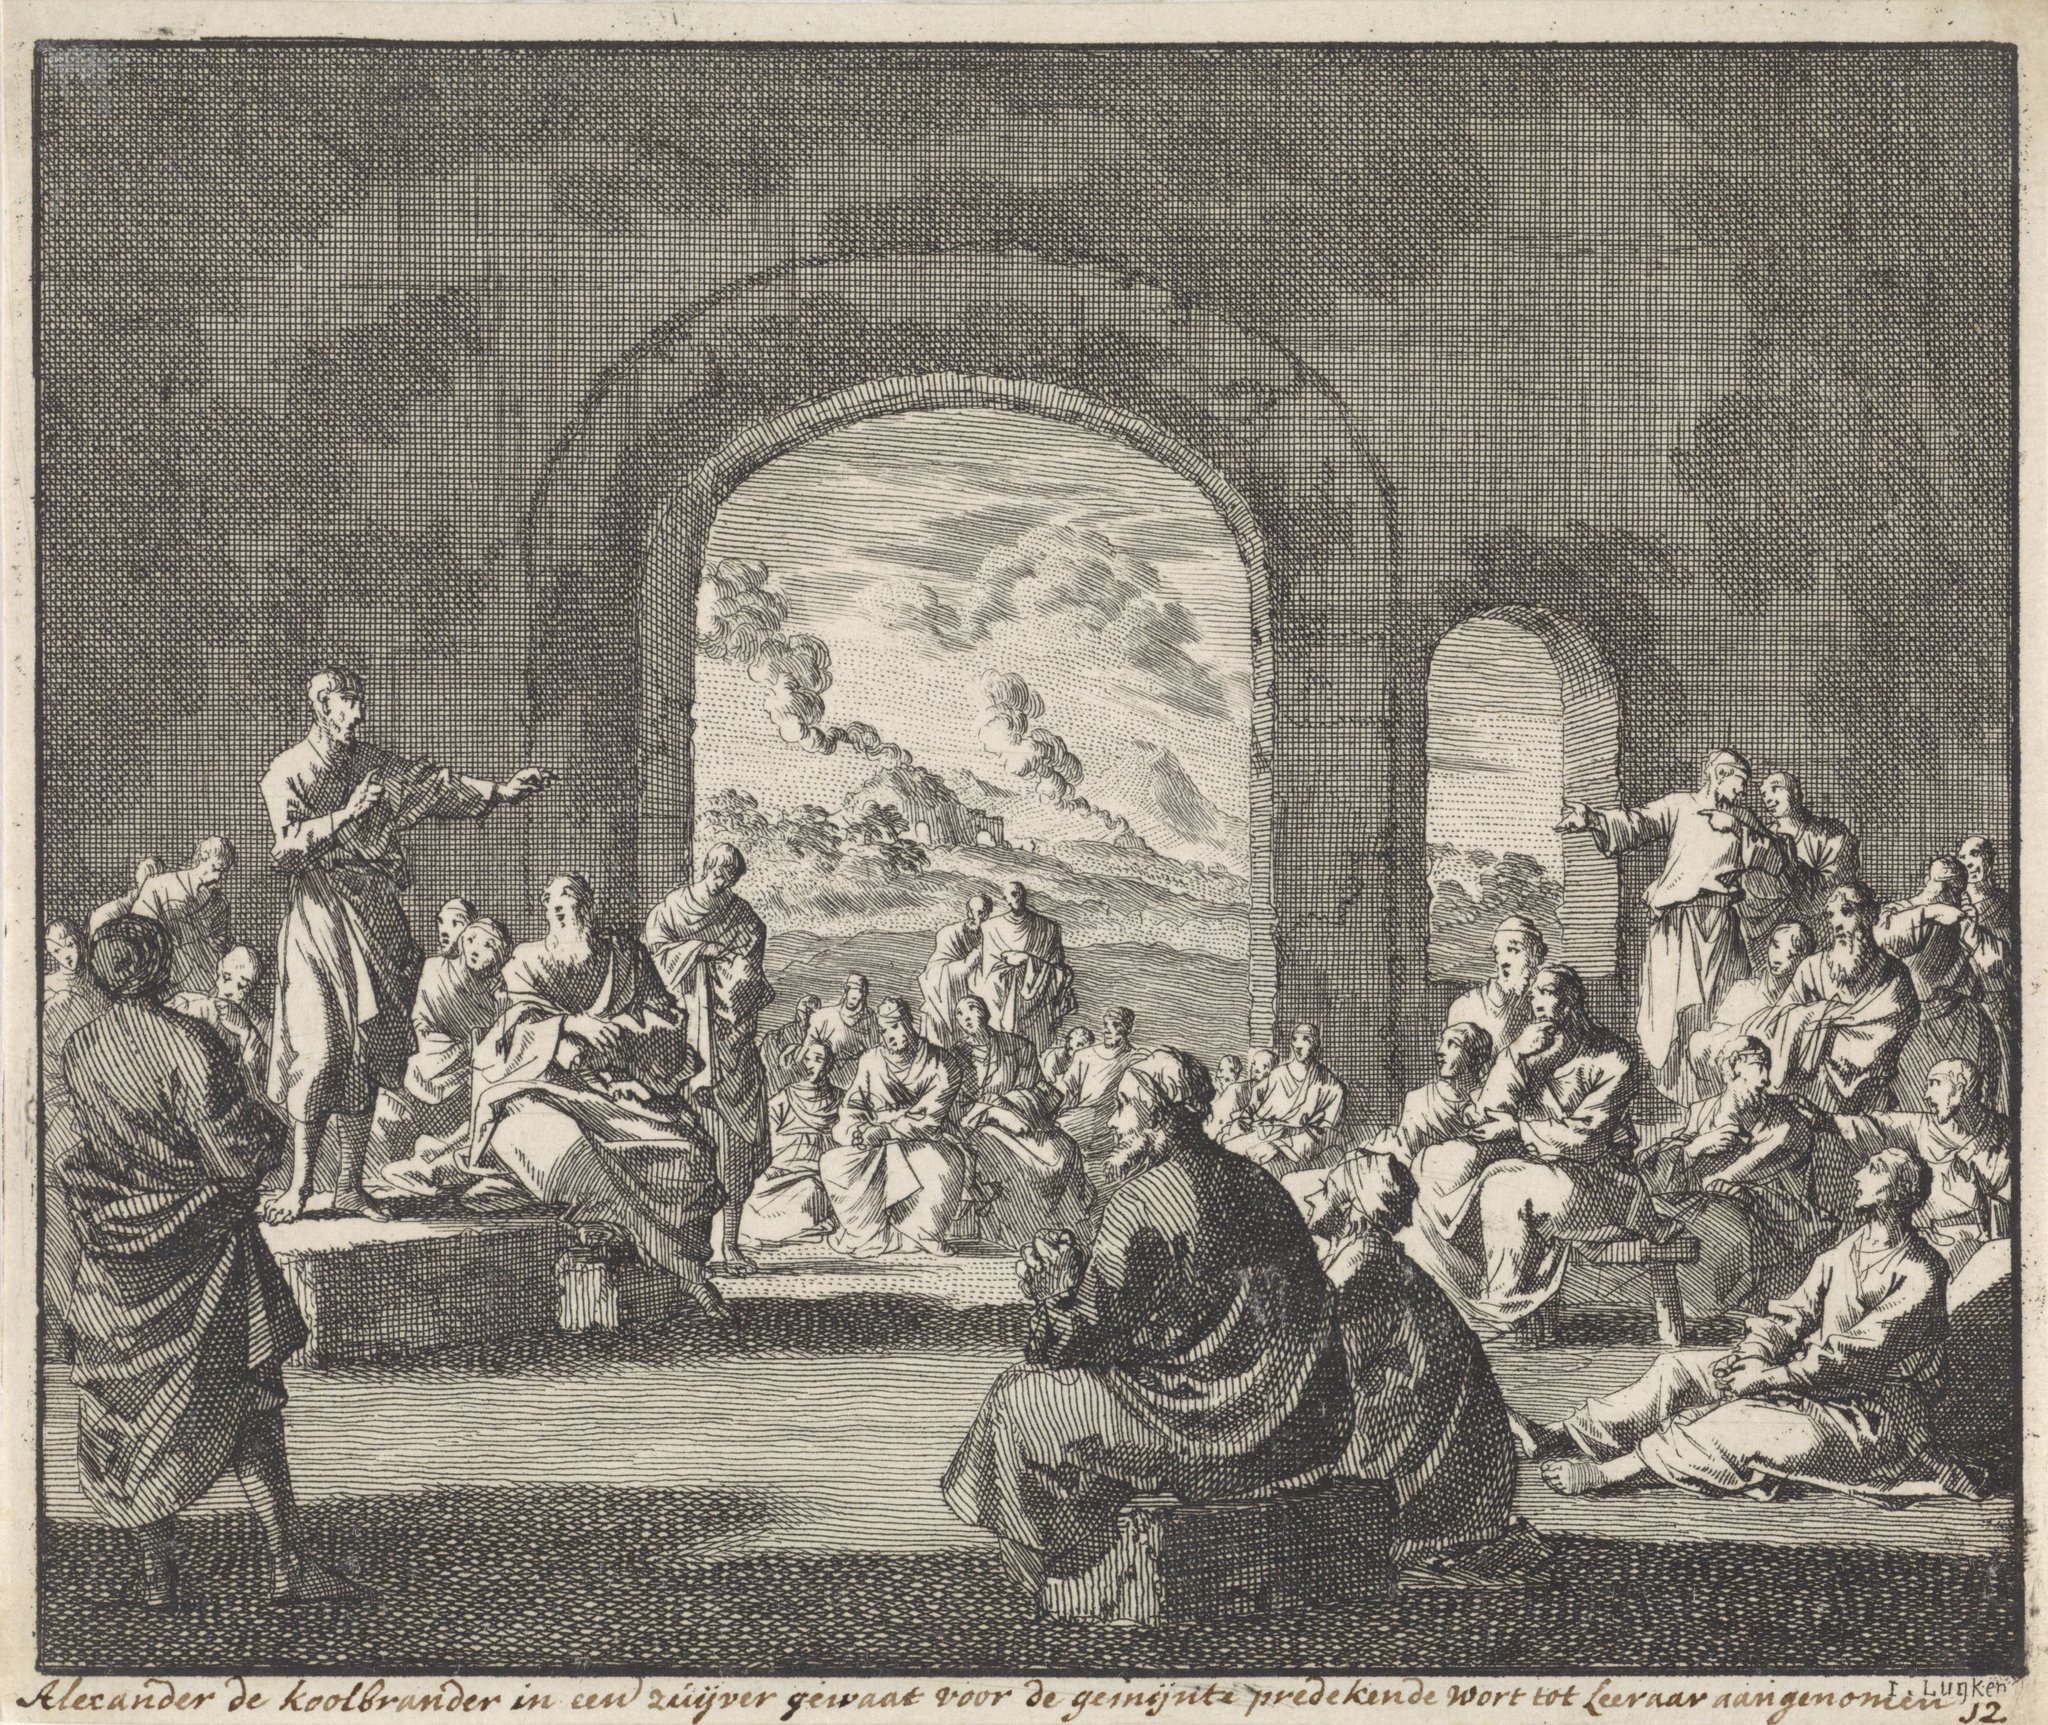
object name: print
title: Alexander de koolbrander in een zuijver gewaat voor de Gemeijnte predikende wordt tot Leeraar aangenomen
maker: jan luyken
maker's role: draughtsman, print maker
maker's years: 1649-1712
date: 1700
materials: paper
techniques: etching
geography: amsterdam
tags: the early christian churches, e.g. armenians, copts, syrians, male saints (with name), preaching (in general)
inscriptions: collector's mark: Lugt 2228, caption: ‘Alexander de koolbrander in een zuijver gewaat voor de Gemeijnte predikende wordt tot Leeraar aangenomen’, number: ‘12’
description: Proefdruk van een boekillustratie voor Arnold, Godfried. Waare afbeelding der eerste christenen. Amsterdam: Jacobus van Hardenberg, Barent Visscher en Jacobus van Nieuweveen, 1700, dl. 1.